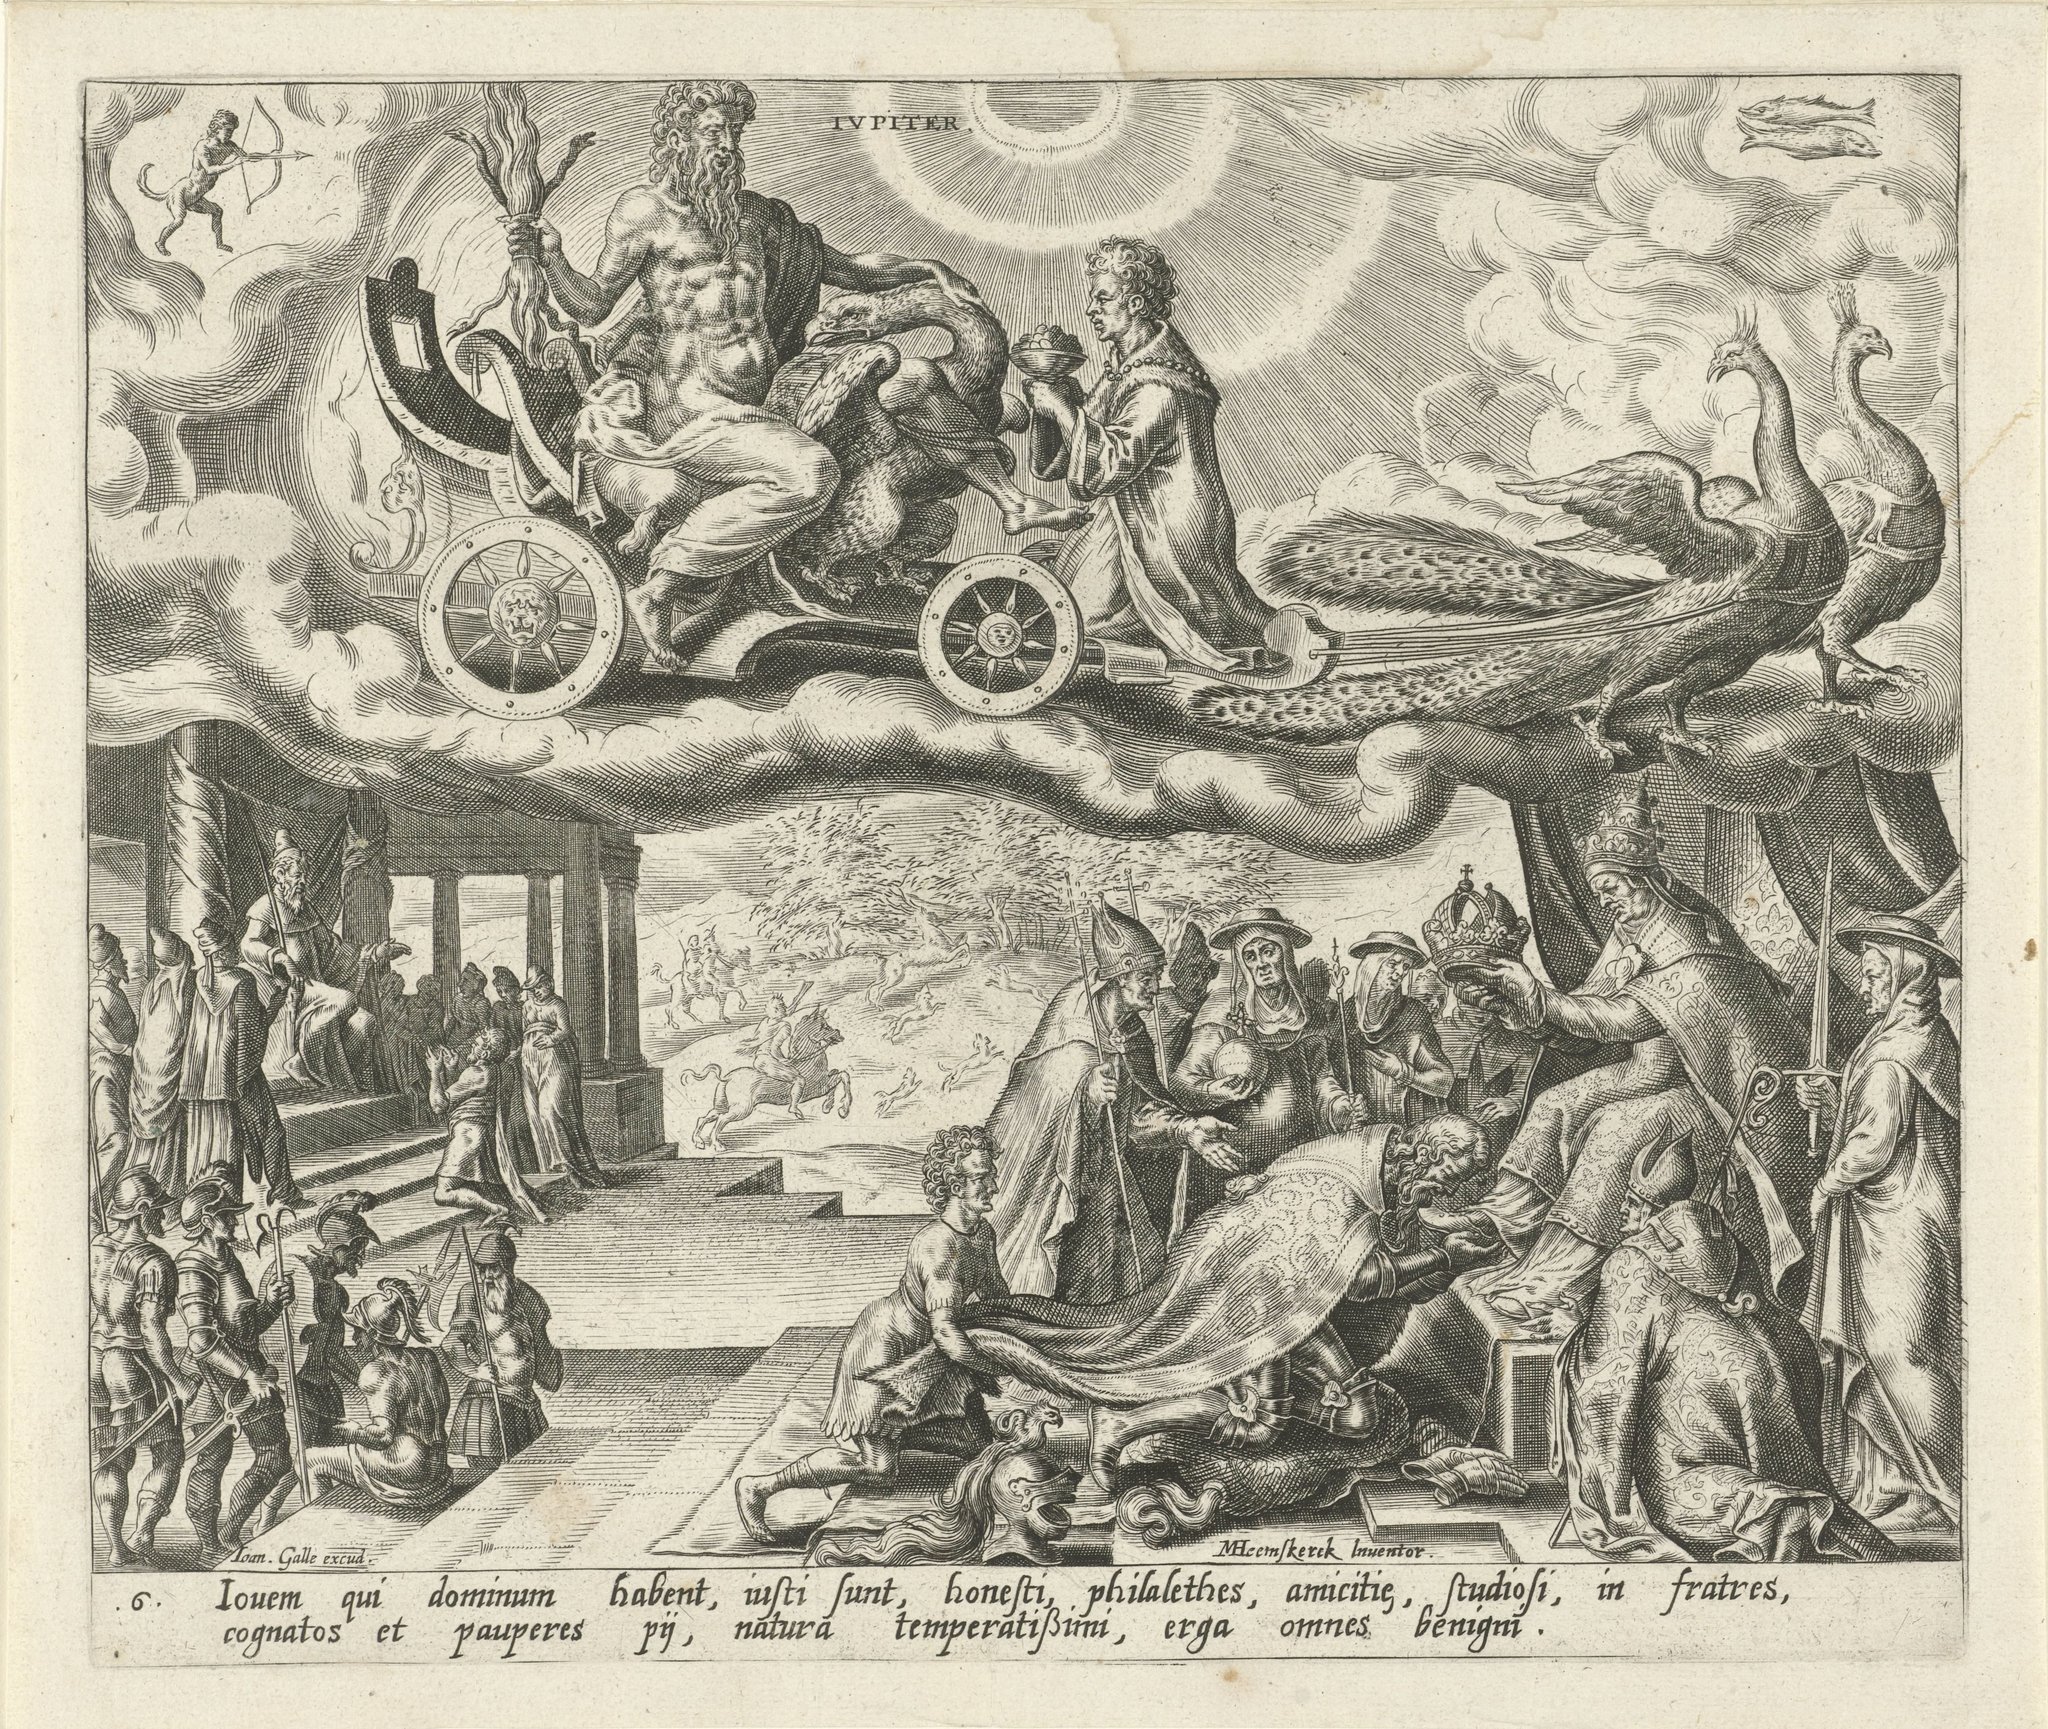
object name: print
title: De planeet Jupiter en zijn kinderen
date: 1566-1570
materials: paper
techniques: engraving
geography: antwerp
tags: hunting, chase, jupiter and his children ('planetenkinder') ~ pisces and sagittarius, ornamental birds: peacock, magistracy, judges, pope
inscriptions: collector's mark: Lugt 2228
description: Prent mogelijk gebruikt in: Speculum diversarum imaginum speculativarum a variis doctis adinventarum, atque ab insignibus pictoribus ac sculptoribus delineatarum. Antwerpen: Johannes Galle, 1638. Of in: Schabaelje, Jan Philipsz. Den grooten figver-bibel. Dat is een afbeeldingh en levendighe vertooningh, van alle de voornaemste historien (...) der gantscher Heyliger Schrift, in schoone copere figueren (...) verrijckt met leersame verclaeringhen over de selve figueren. Alkmaar: Simon Cornelisz Brekegeest, Amsterdam: Jan Philipsz. Schabaelje, 1646.